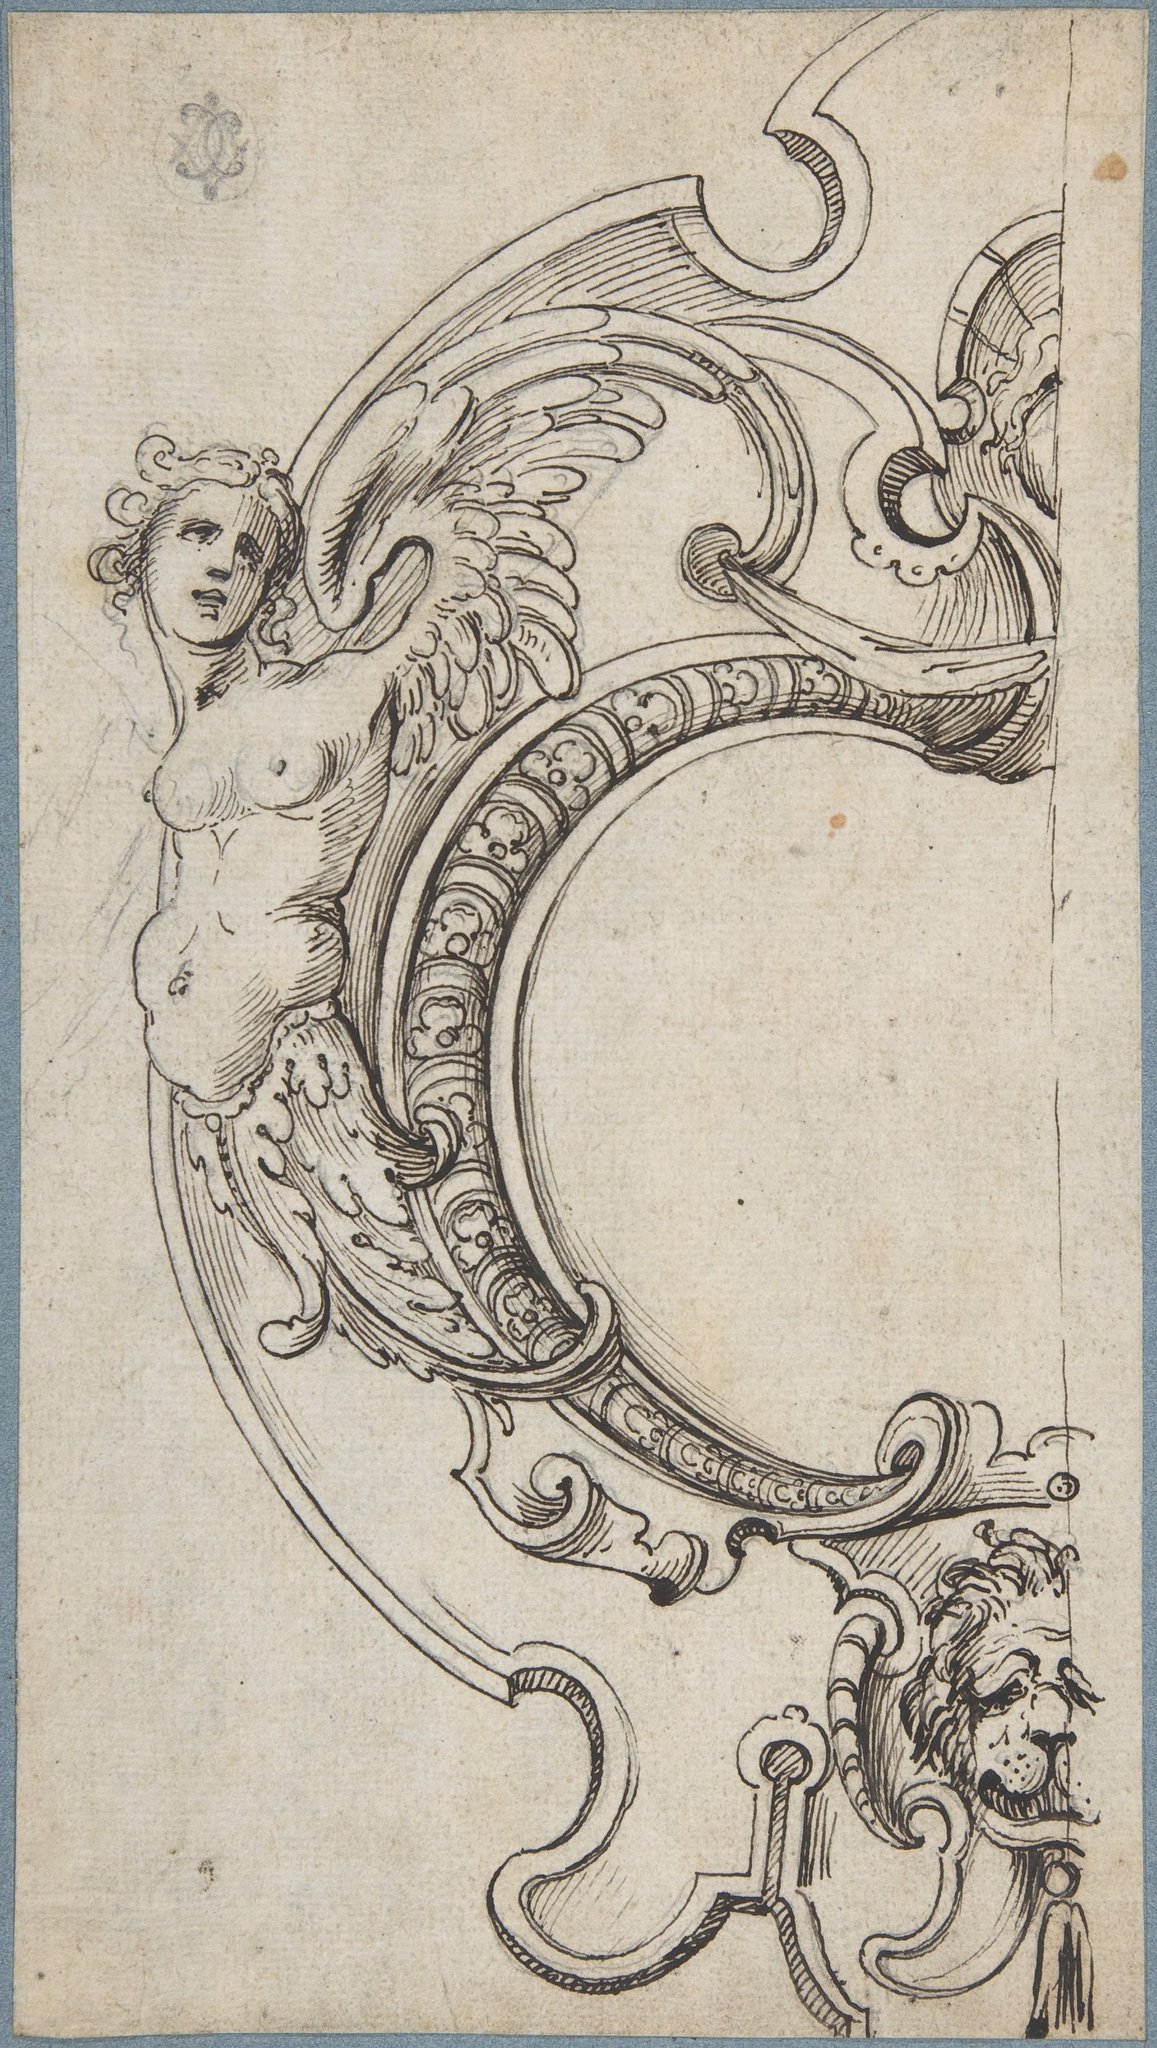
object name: drawing collection ornament architecture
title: Half of a Cartouche with a Female Figure on the Left and a Lion's Head on the Bottom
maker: anonymous, italian, 17th century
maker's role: artist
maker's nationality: italian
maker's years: 1600-1700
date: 1601-1700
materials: ink, drawing material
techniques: pen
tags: cartouches,women,lions